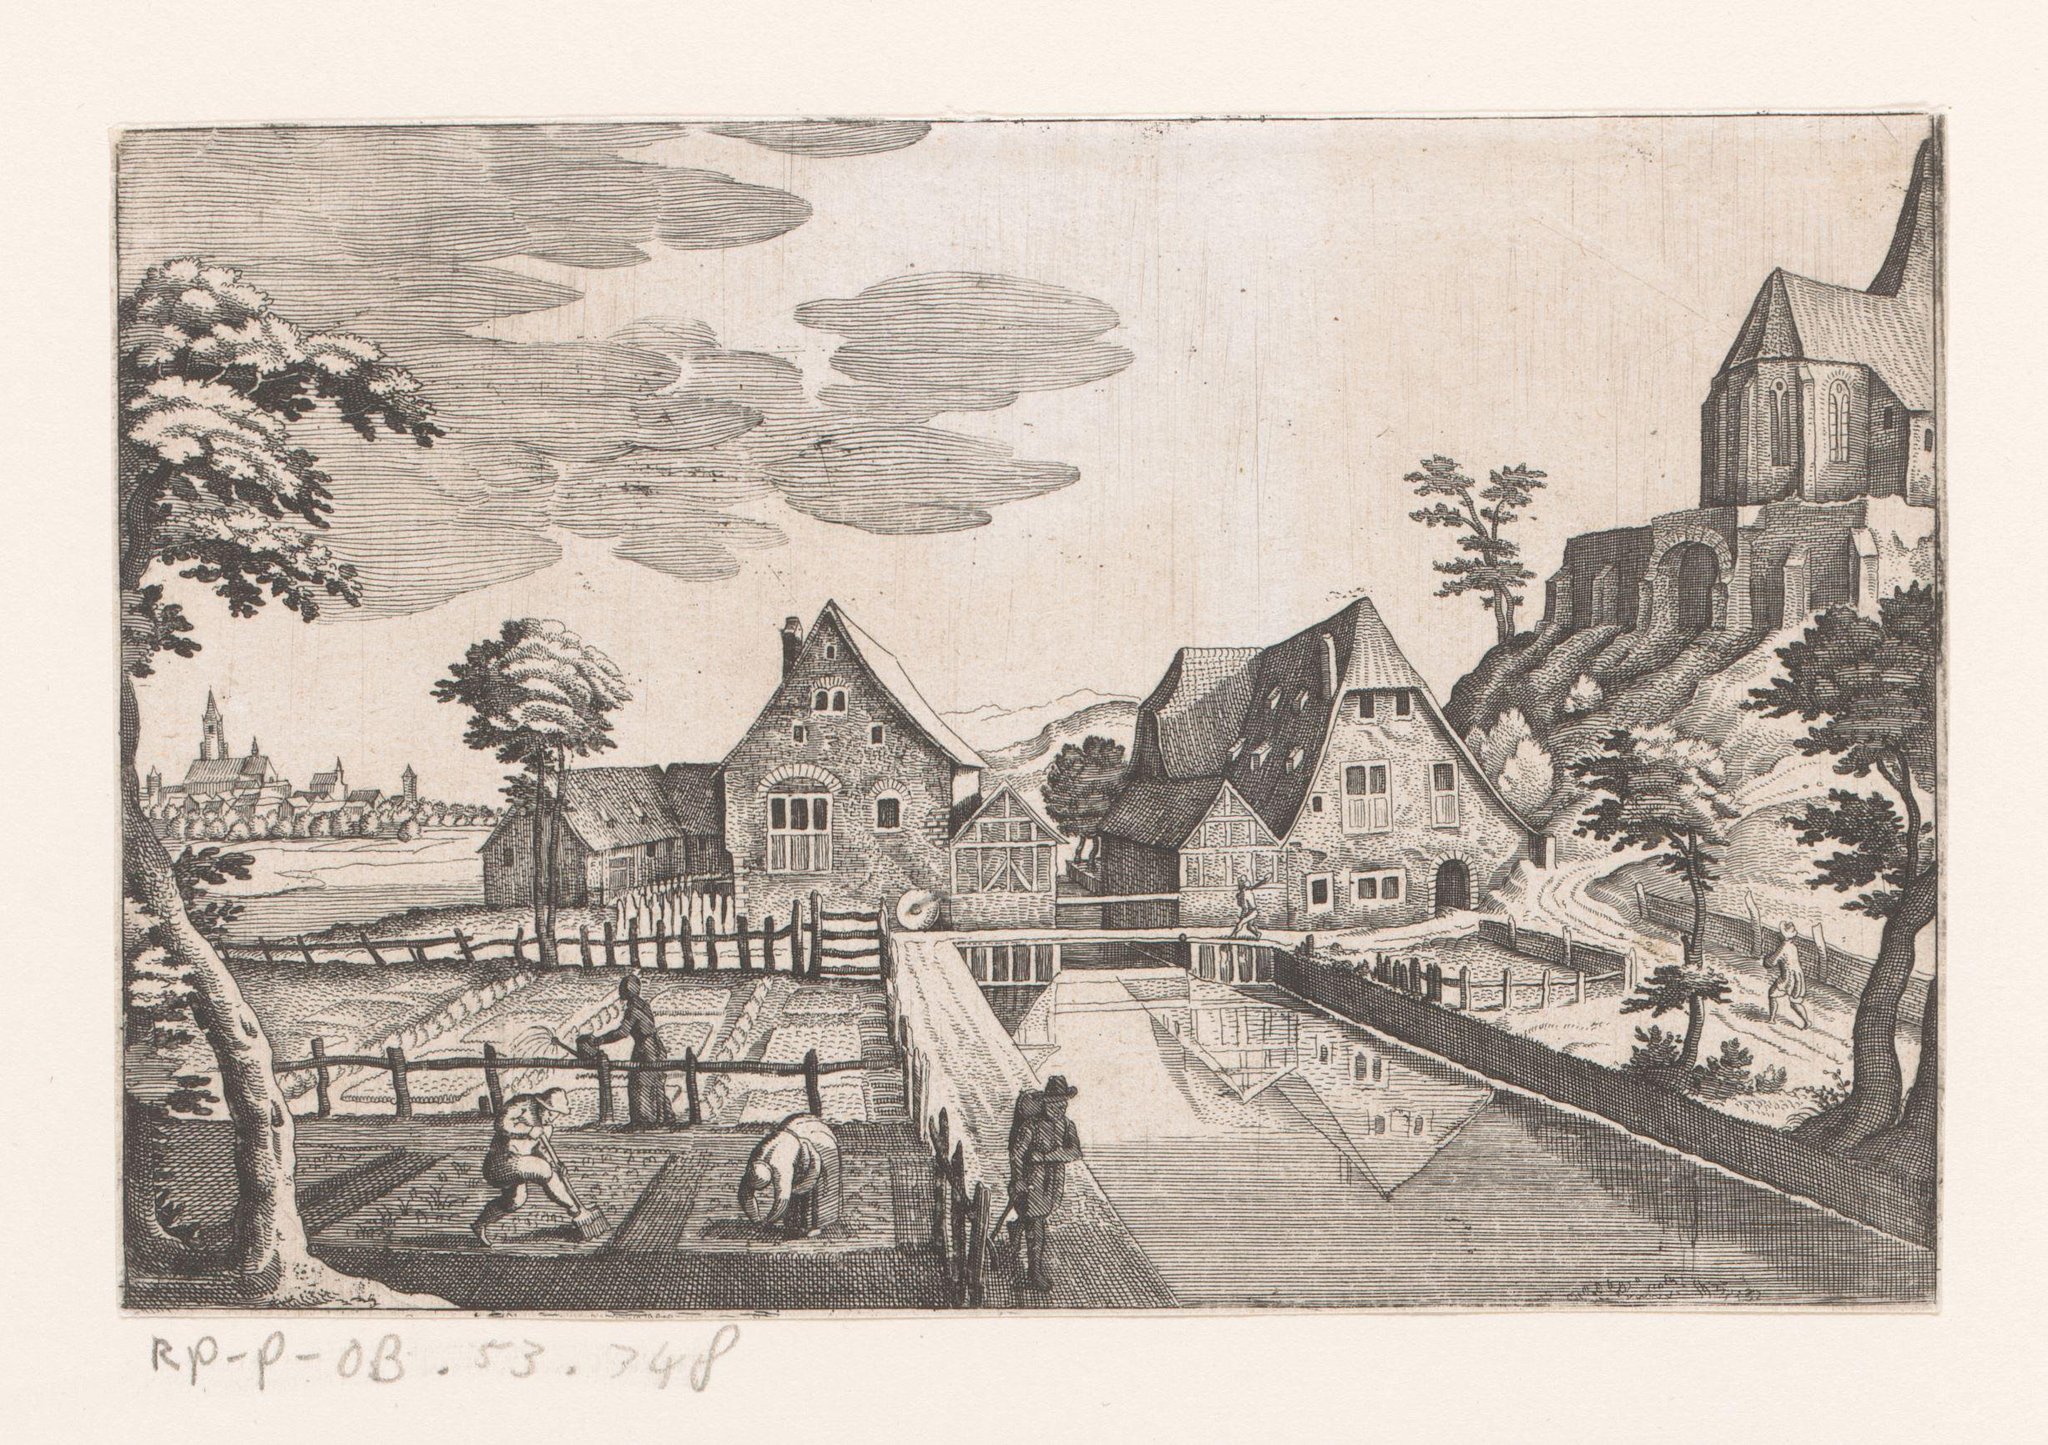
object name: print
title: Gezicht op het dorp Berg bij Stuttgart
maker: Anonymous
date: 1625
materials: paper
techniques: etching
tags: city-view, and landscape with man-made constructions, farm (building)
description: Kopie in dezelfde richting naar de prent van Matthäus Merian I (Hollstein 370).